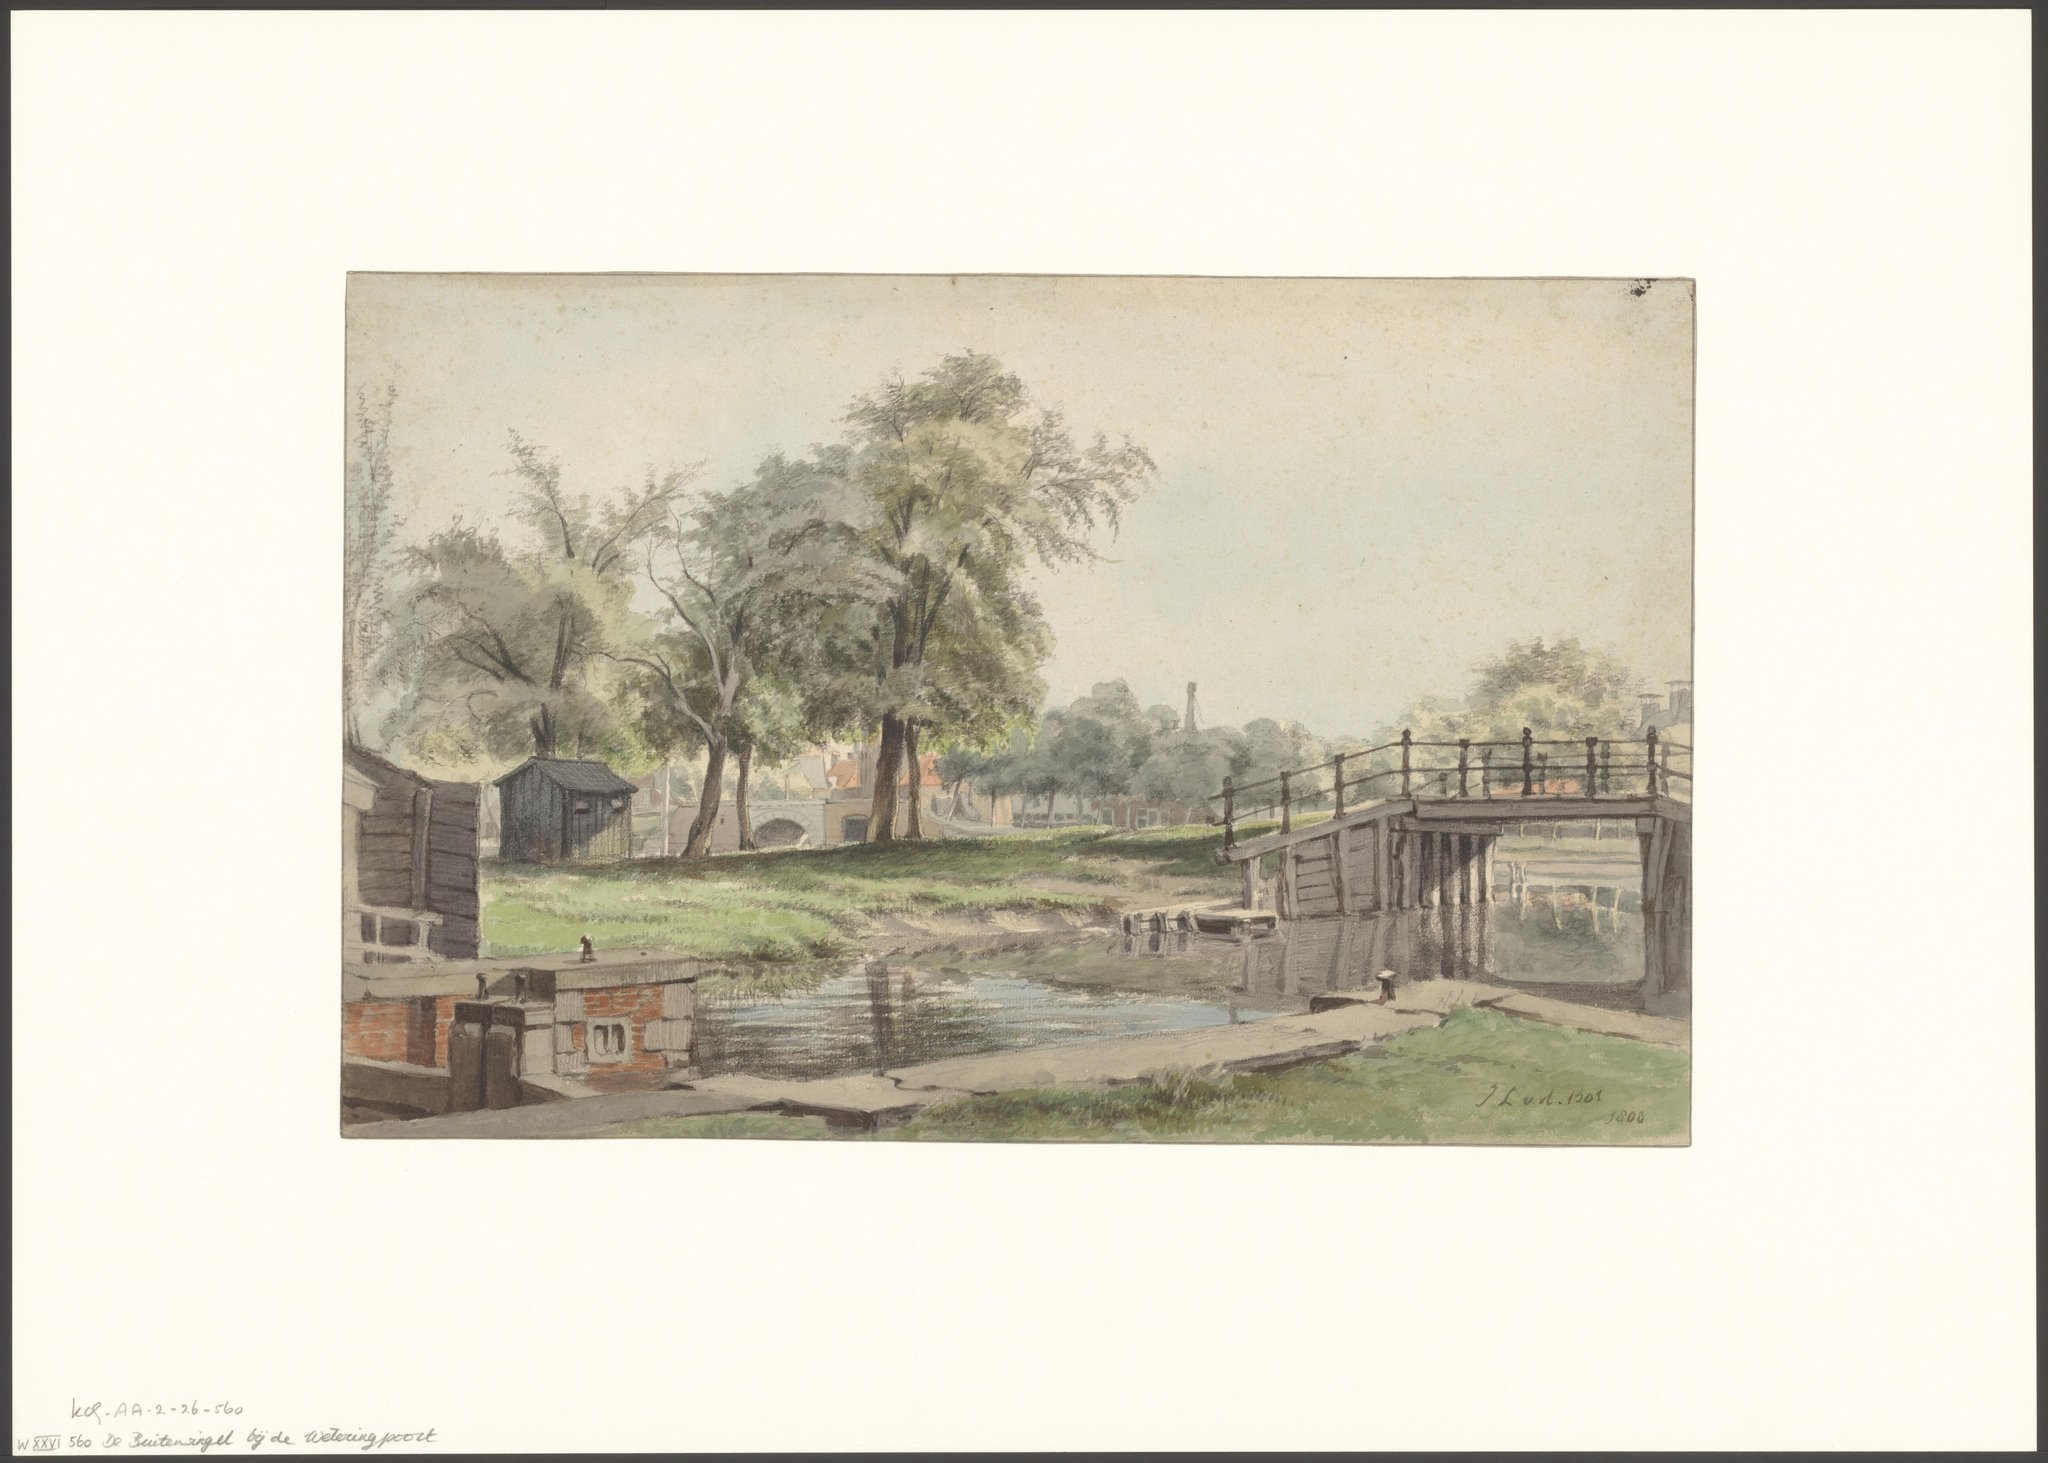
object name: drawing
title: Gezicht op het Singel bij de Weteringpoort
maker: johannes ludovicus van den bos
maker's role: draughtsman, print maker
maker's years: 1800-1827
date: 1808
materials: chalk, paper, watercolor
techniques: brush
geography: amsterdam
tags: city-view in general; 'veduta', canal, bridge in city across river, canal, etc.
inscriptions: inscription: ‘buiten singel bij de Wetering poort’, signature and date: ‘JL vd. Bos / 1808’, collector's mark: Lugt 800a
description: Tekening binnen de Atlas Van Eck ingedeeld op wijknummer 26.